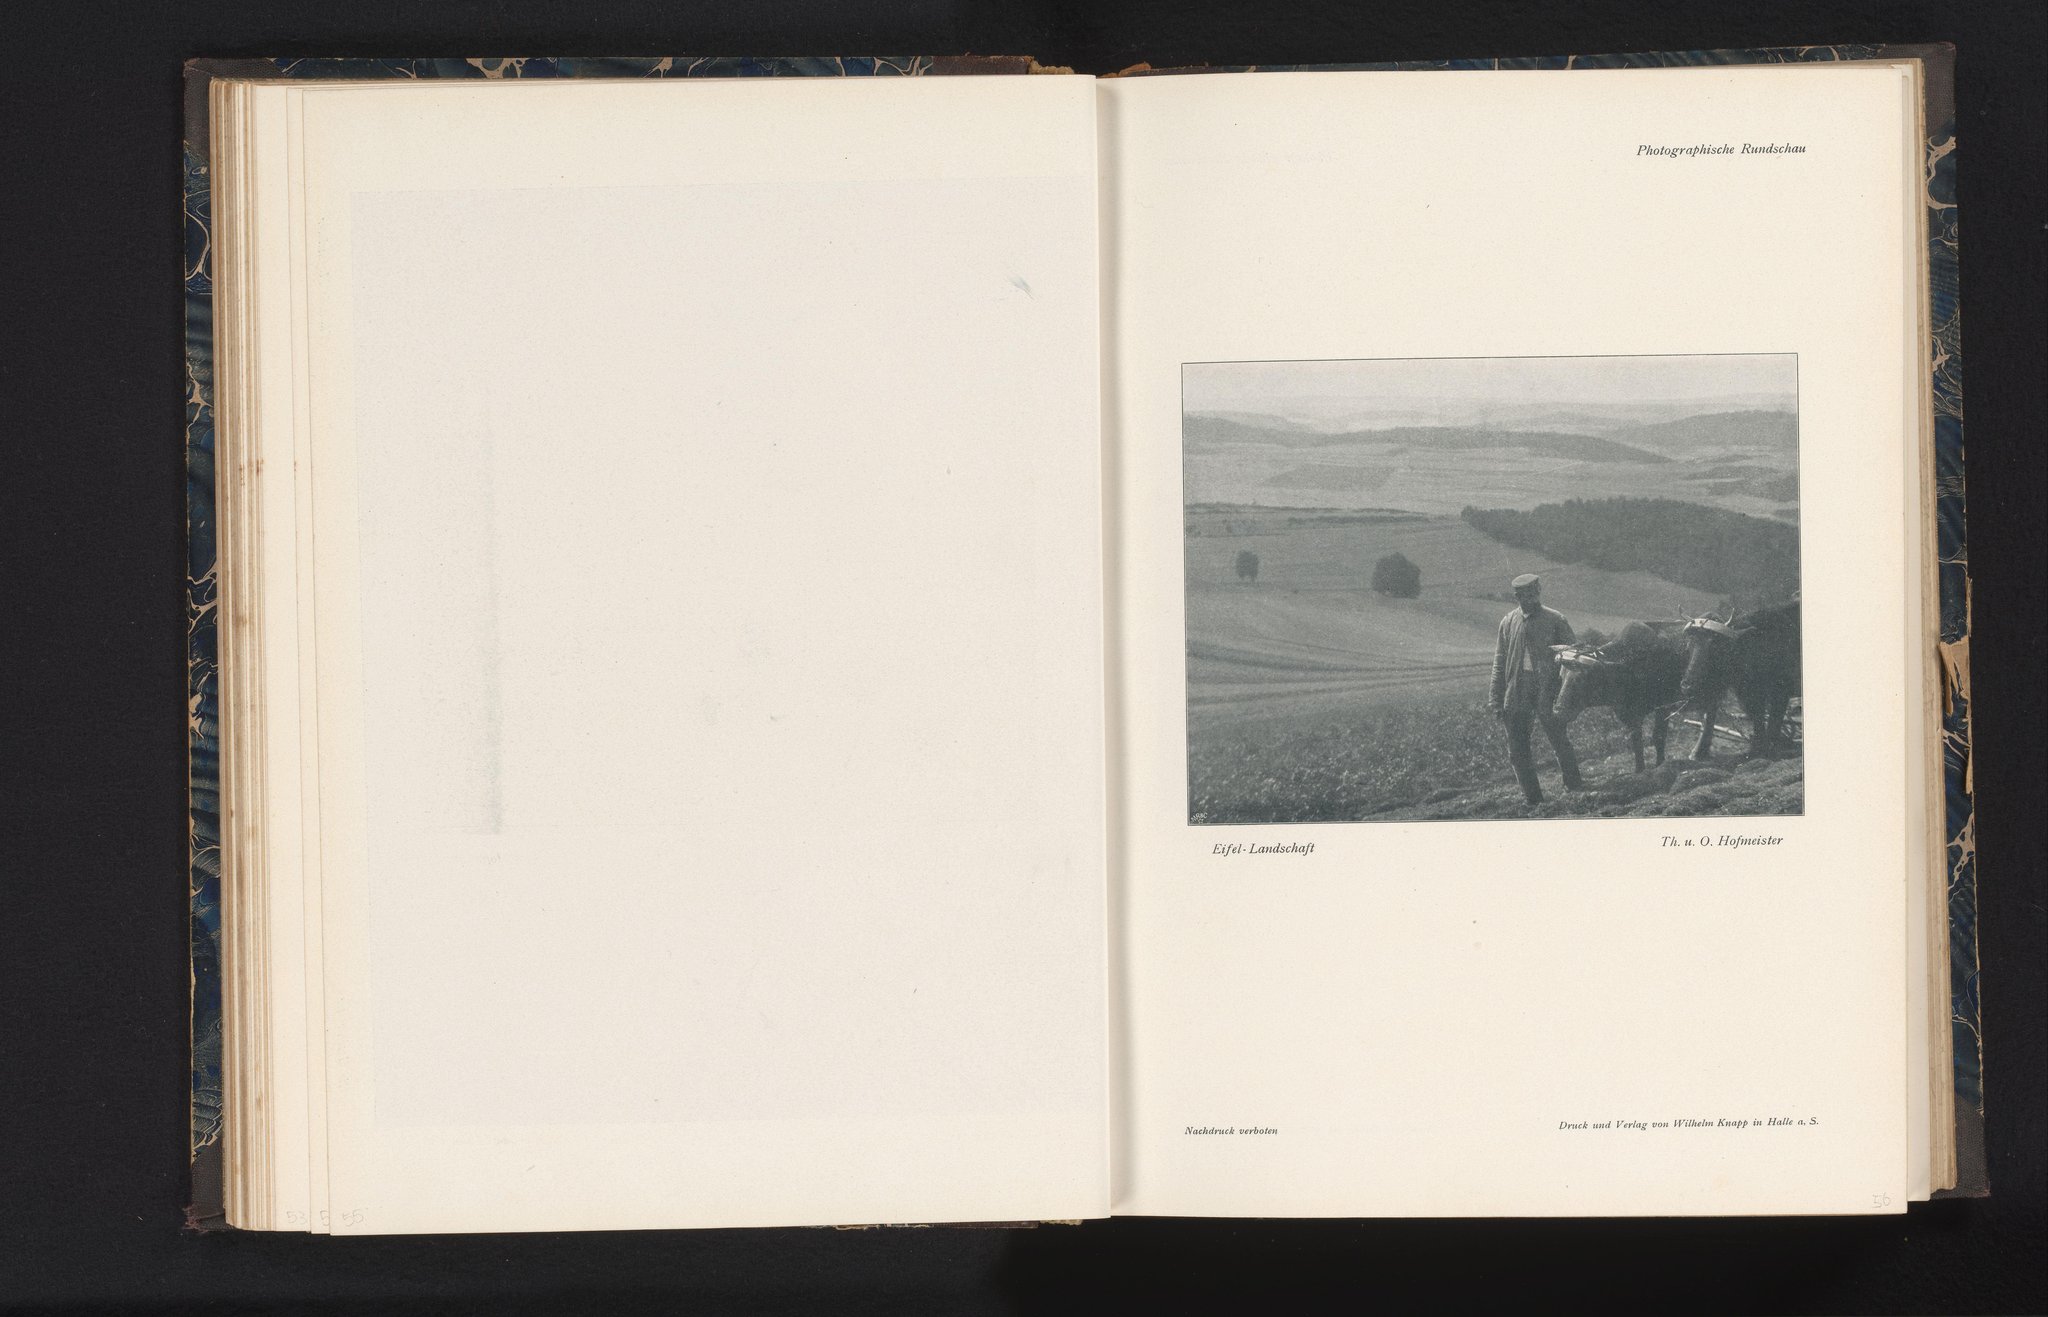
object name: photomechanical print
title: Eifel - Landschaft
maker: th. u. o. hofmeister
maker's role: fotograaf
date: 1897-1902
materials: paper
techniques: autotype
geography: halle an der saale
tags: cow, landscapes, anonymous historical person portrayed